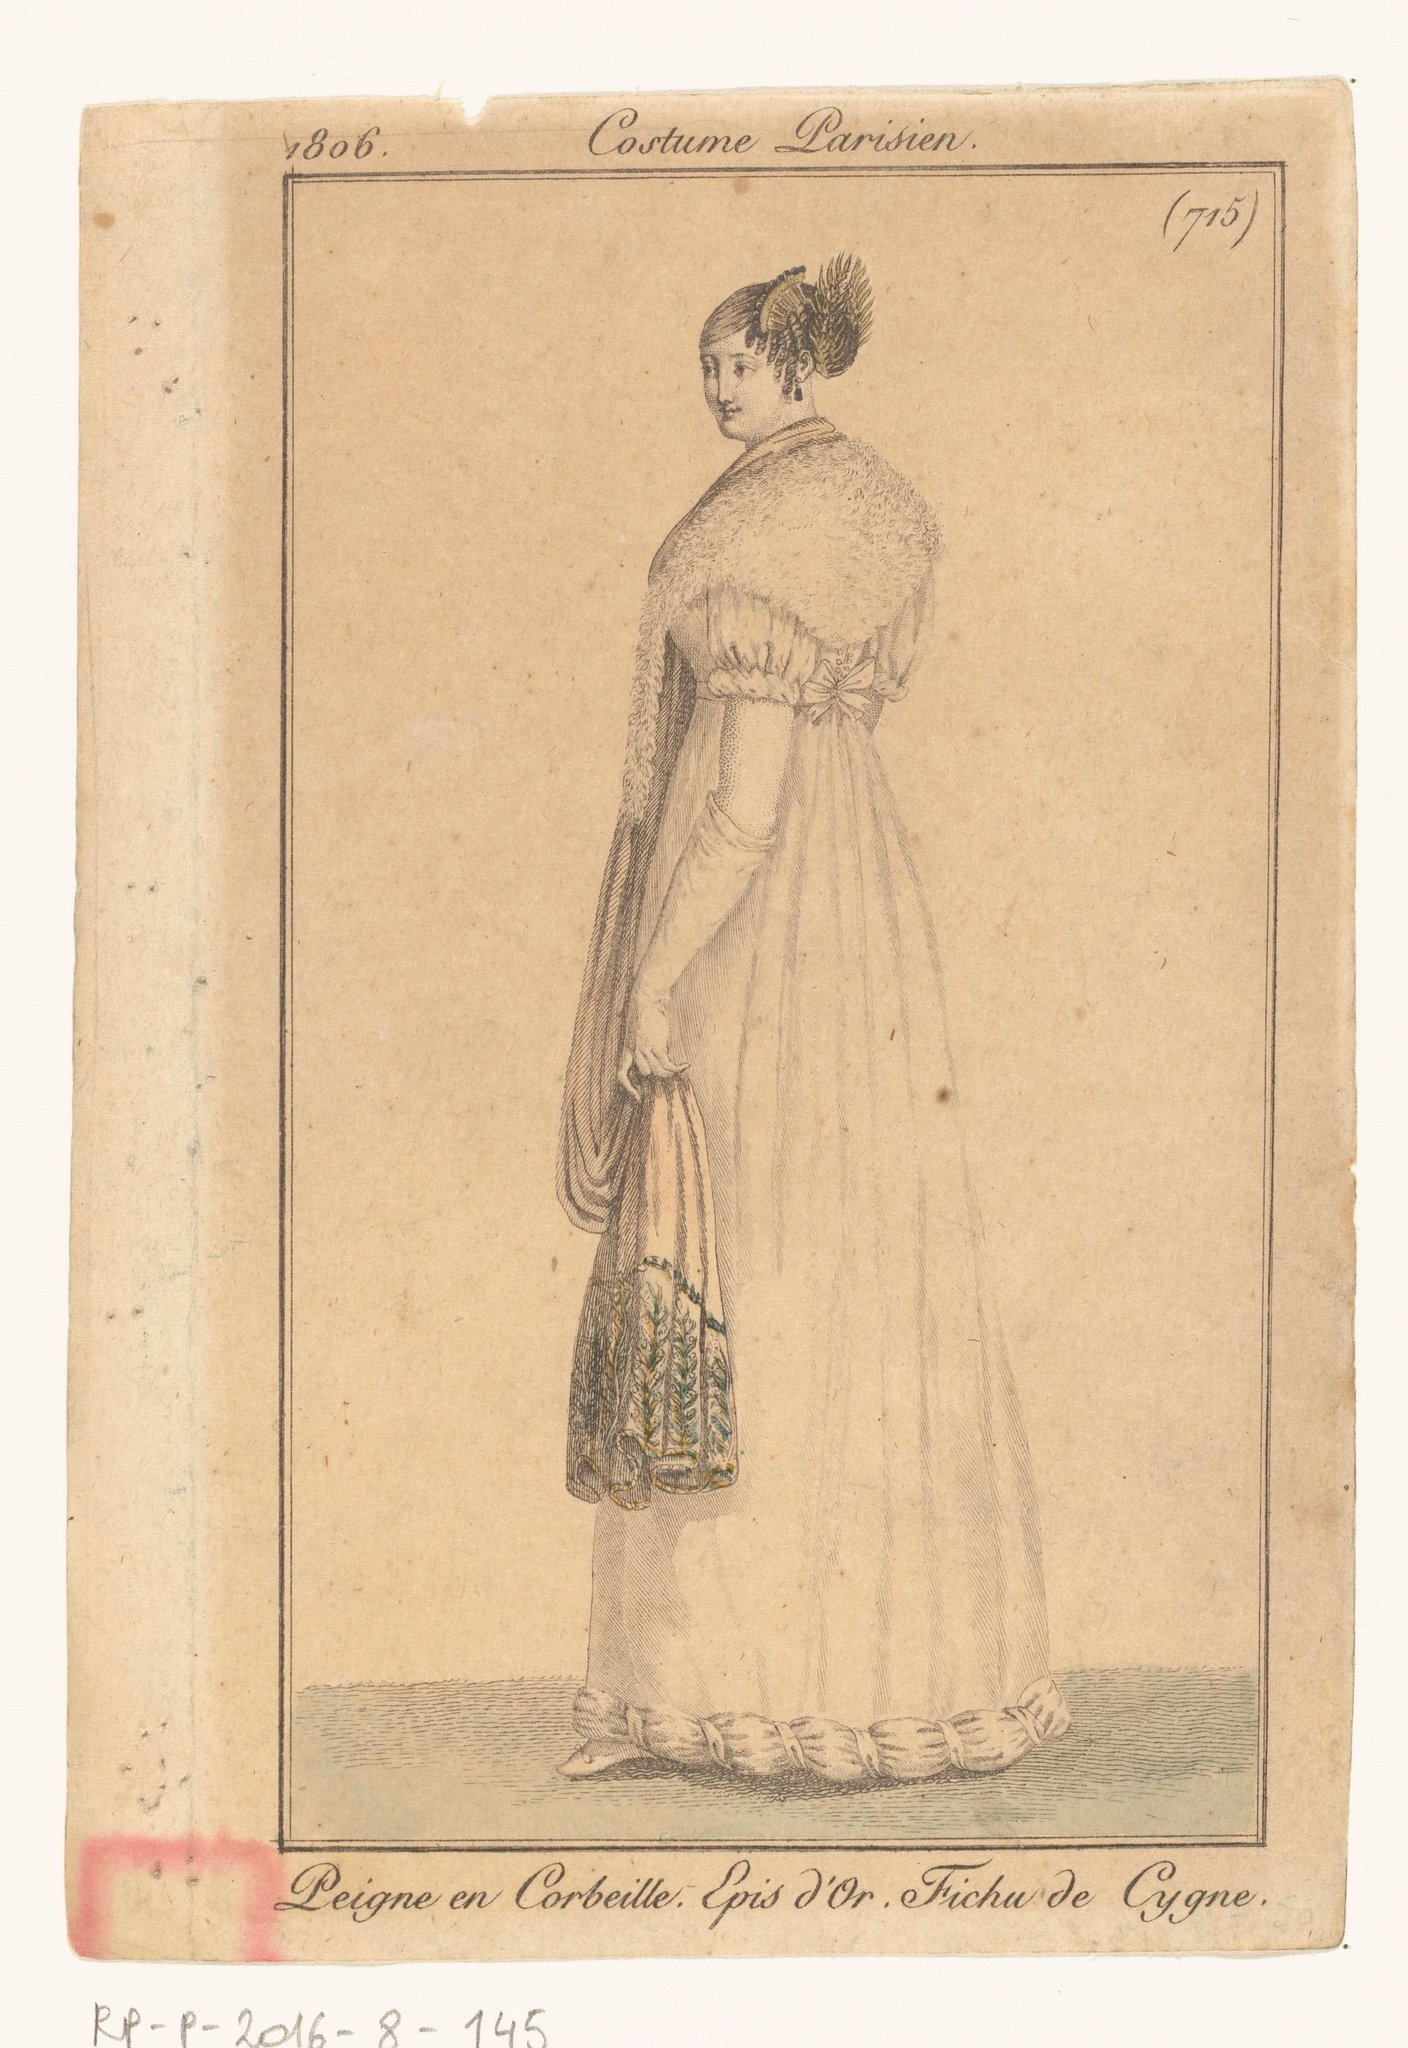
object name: fashion print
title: Journal des Dames et des modes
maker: Anonymous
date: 1806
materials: paper, ink, watercolor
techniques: etching, hand coloring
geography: france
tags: fashion plates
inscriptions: collector's mark: Lugt 2228